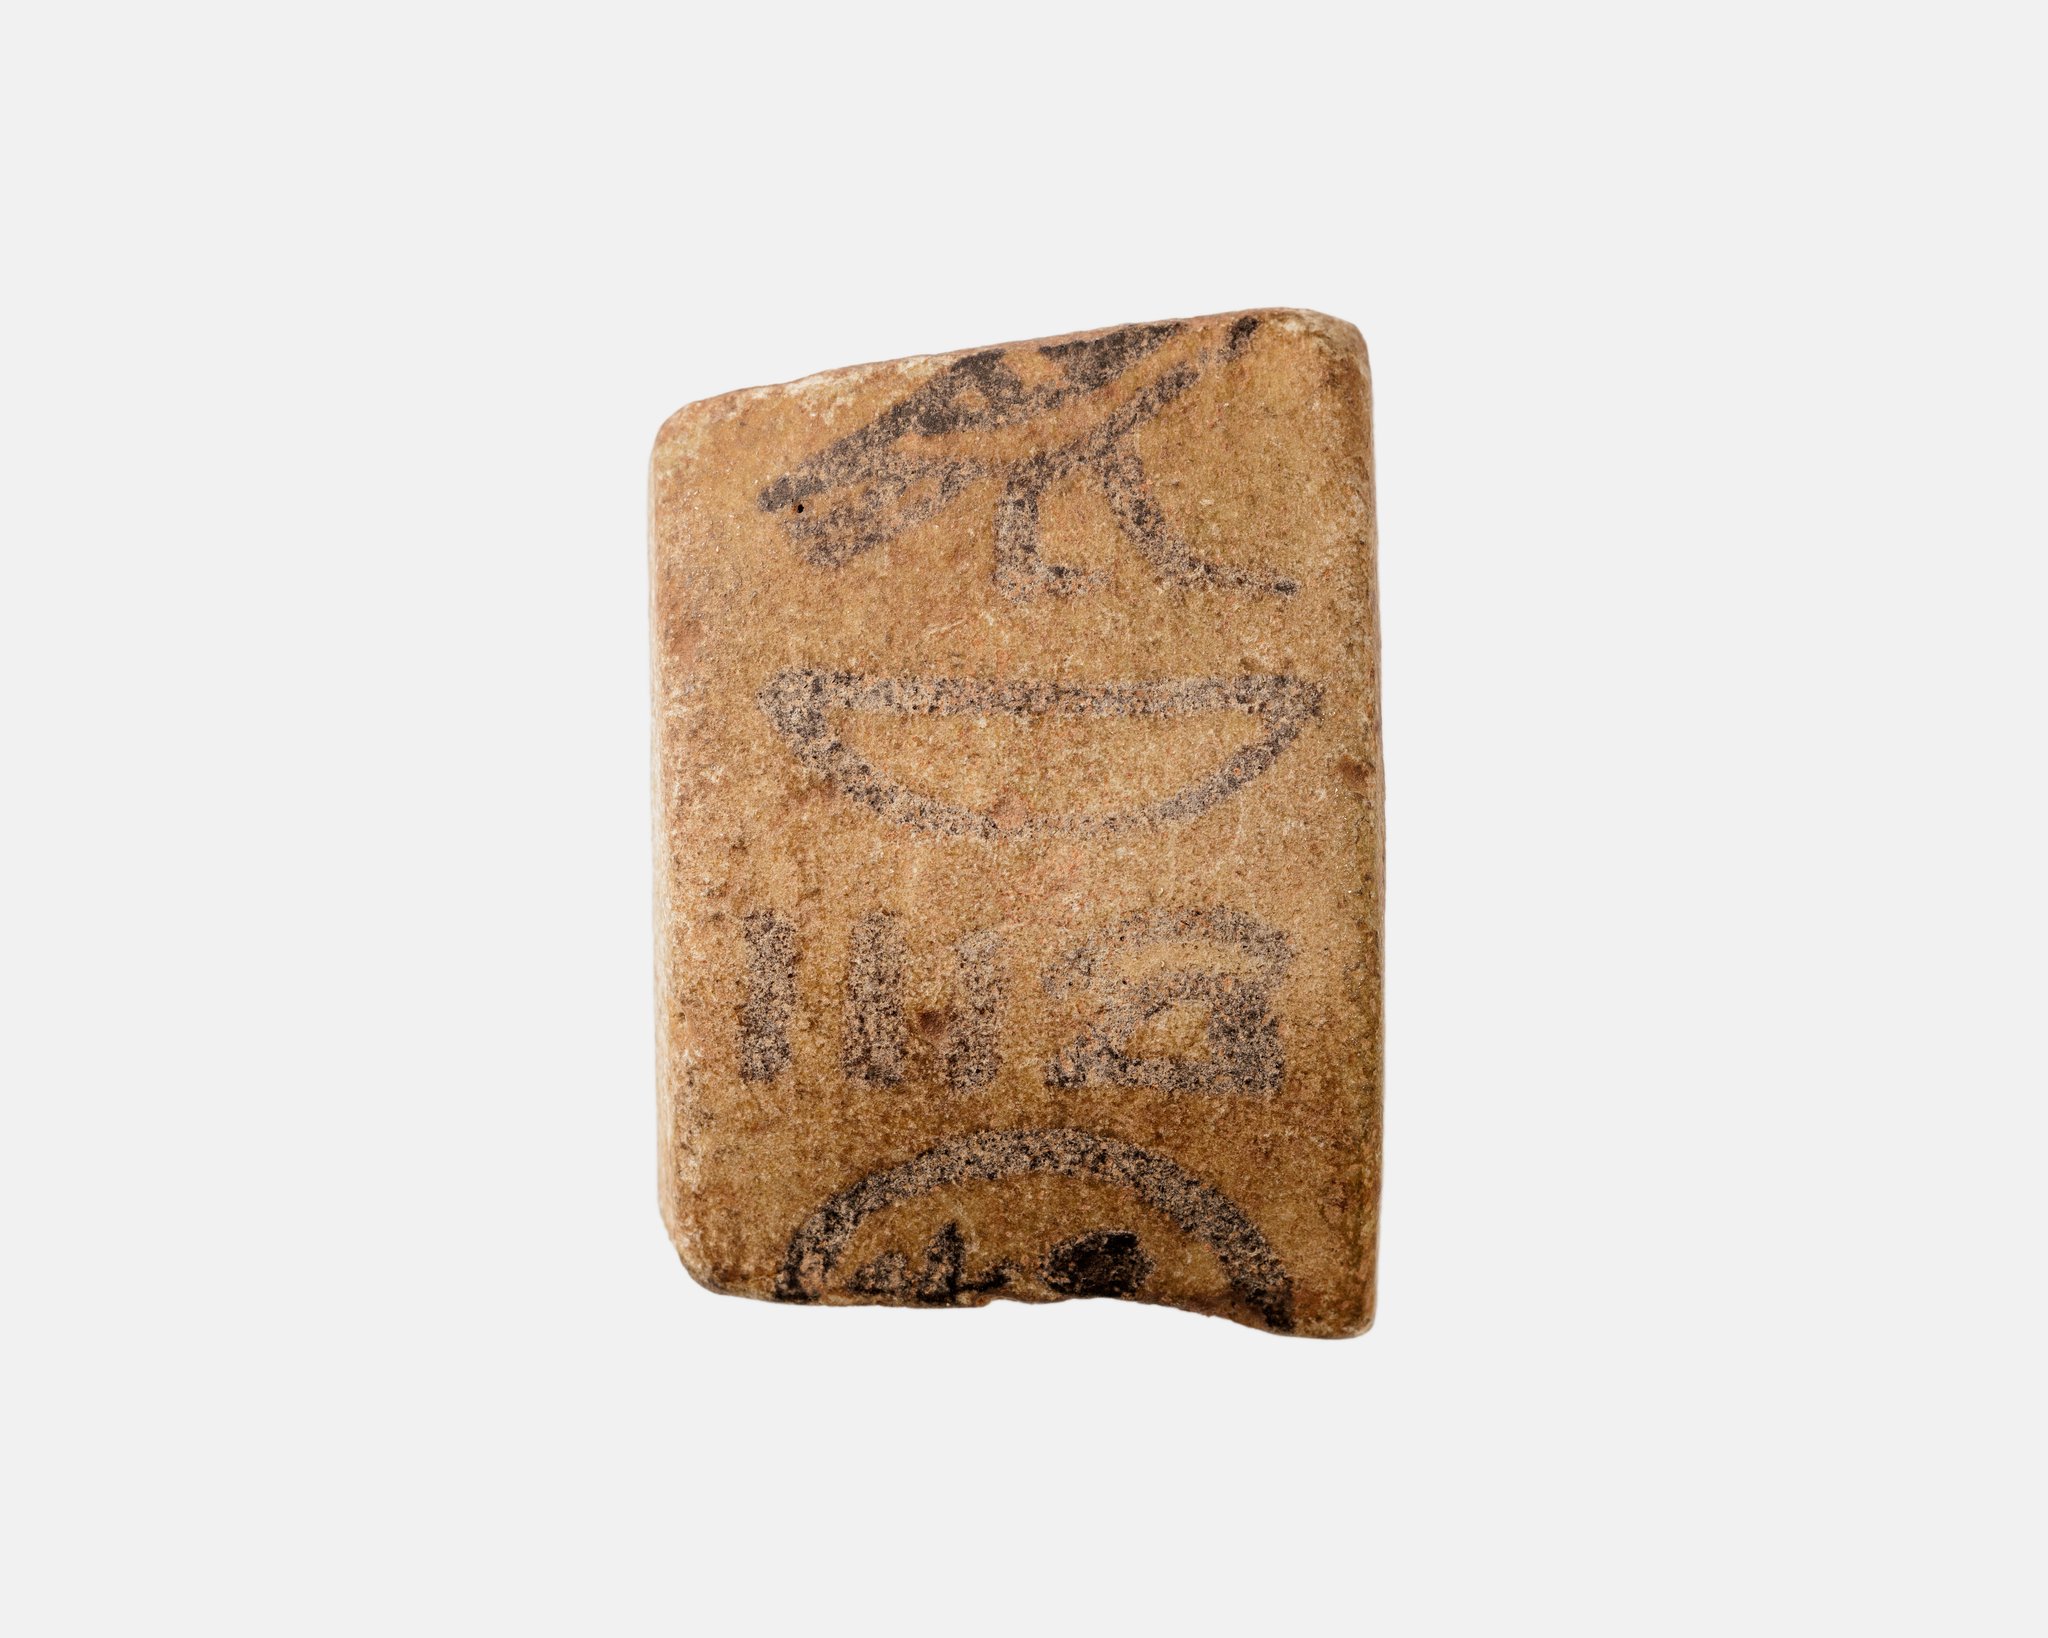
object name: votive bracelet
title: Fragment of a votive bracelet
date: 1295-1070 BCE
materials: faience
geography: egypt